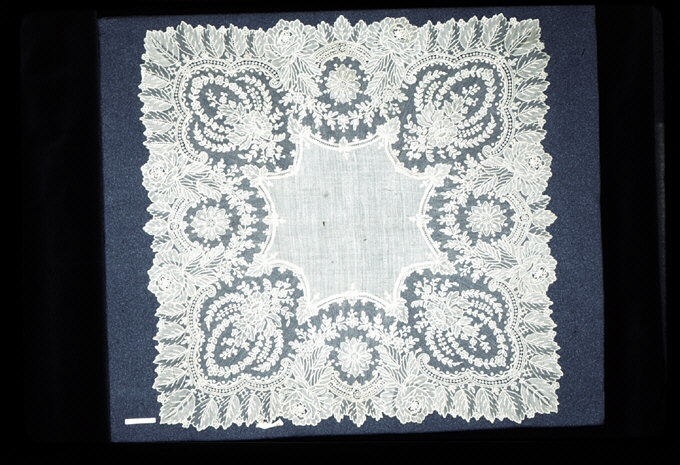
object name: handkerchief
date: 1867-1900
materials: linen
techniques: lace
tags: flowers